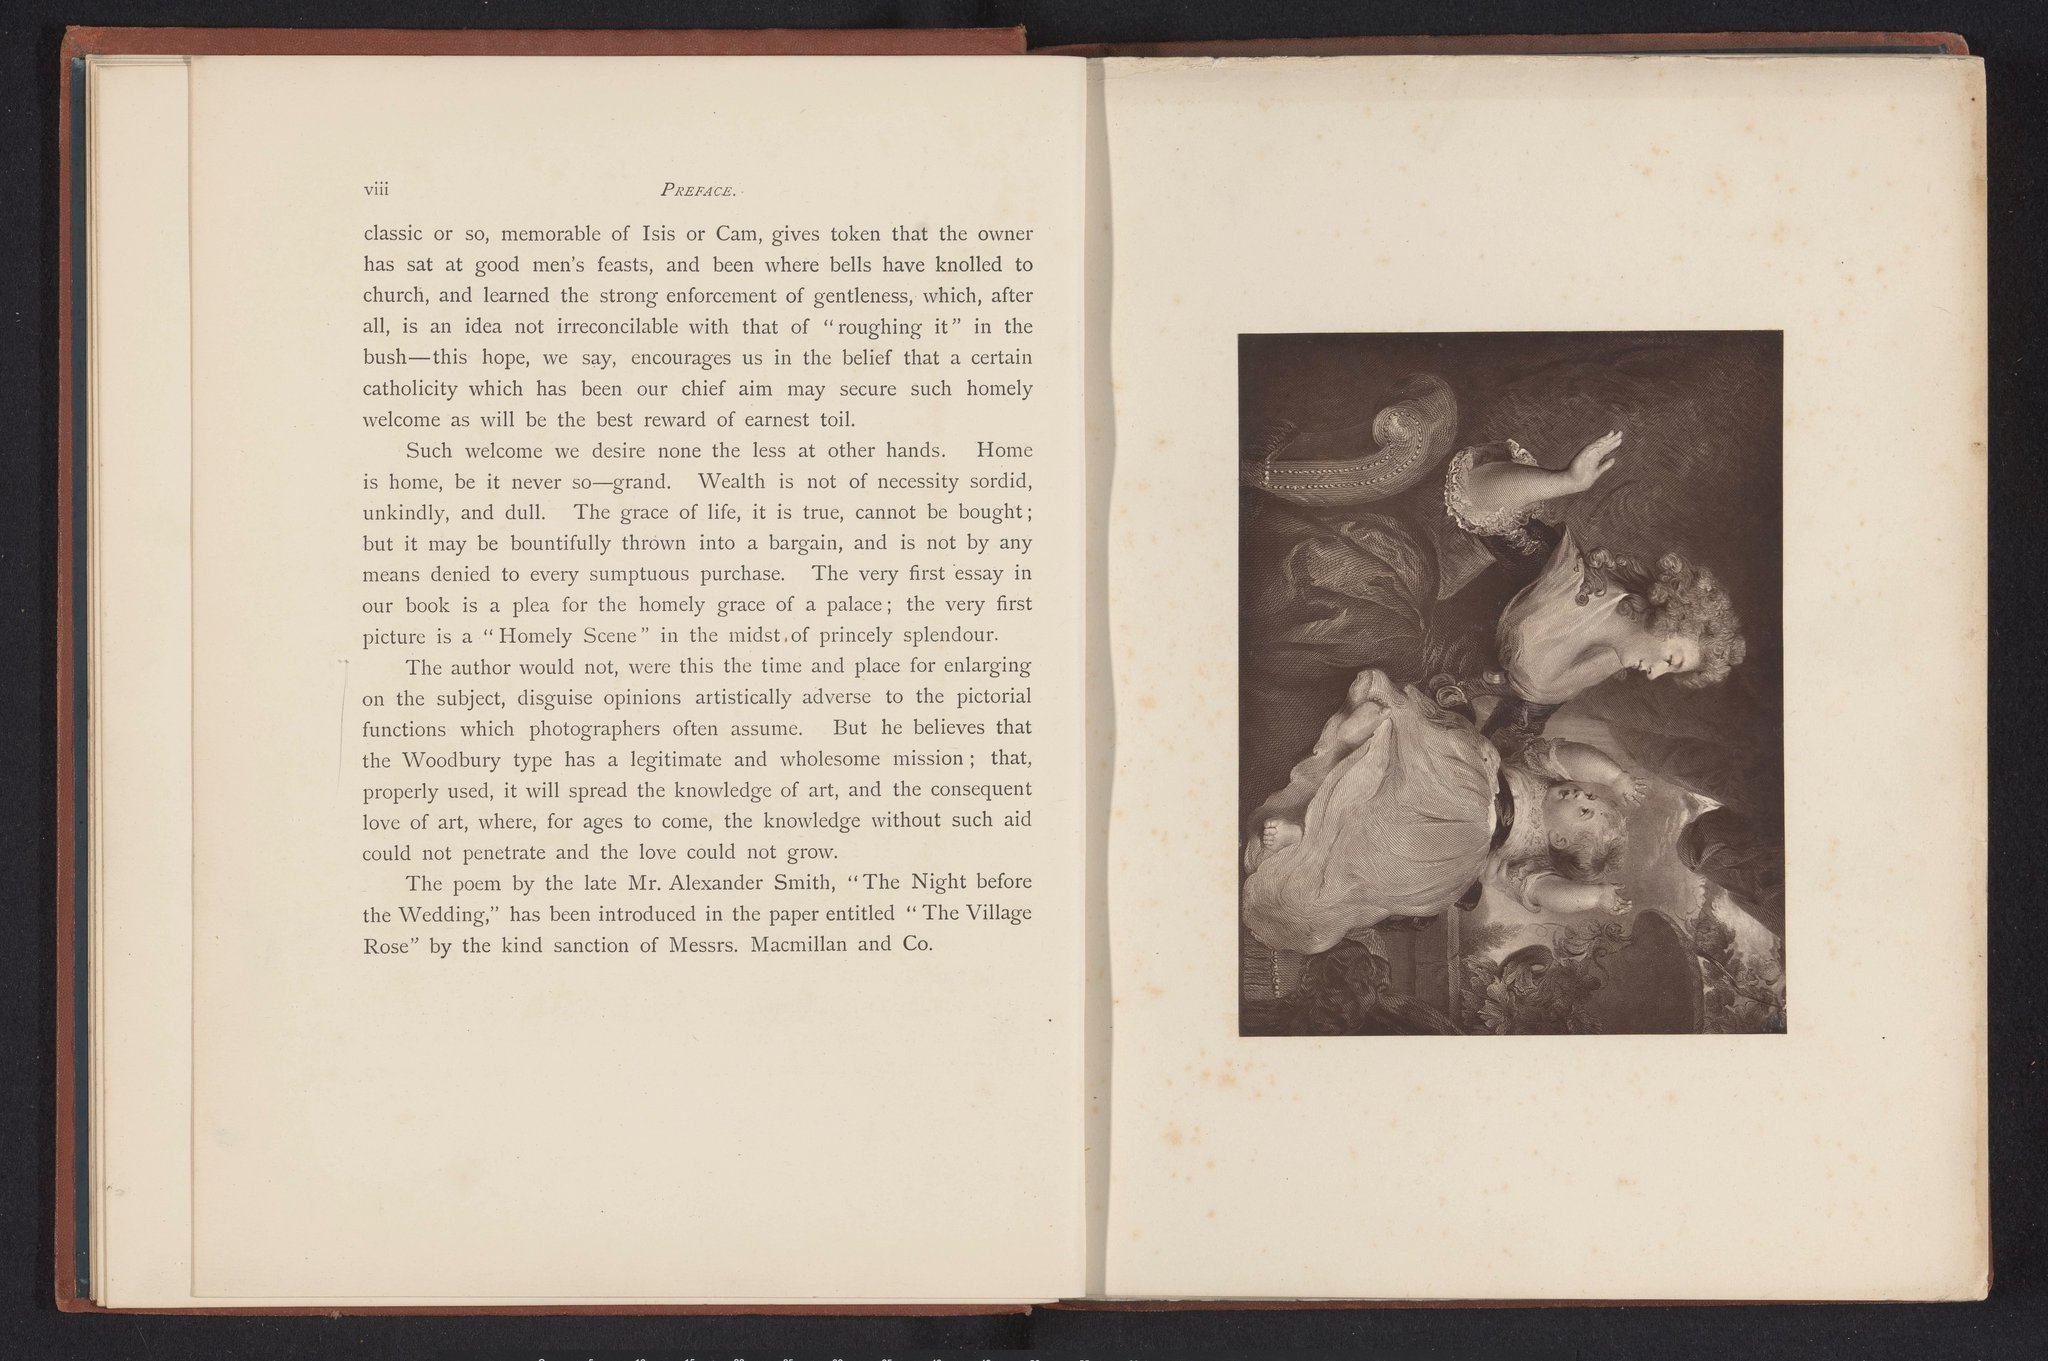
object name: photomechanical print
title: Fotoreproductie van een prent naar een schilderij, voorstellende een moeder met kind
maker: Anonymous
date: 1861-1871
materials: paper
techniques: woodburytype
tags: mother and baby or young child